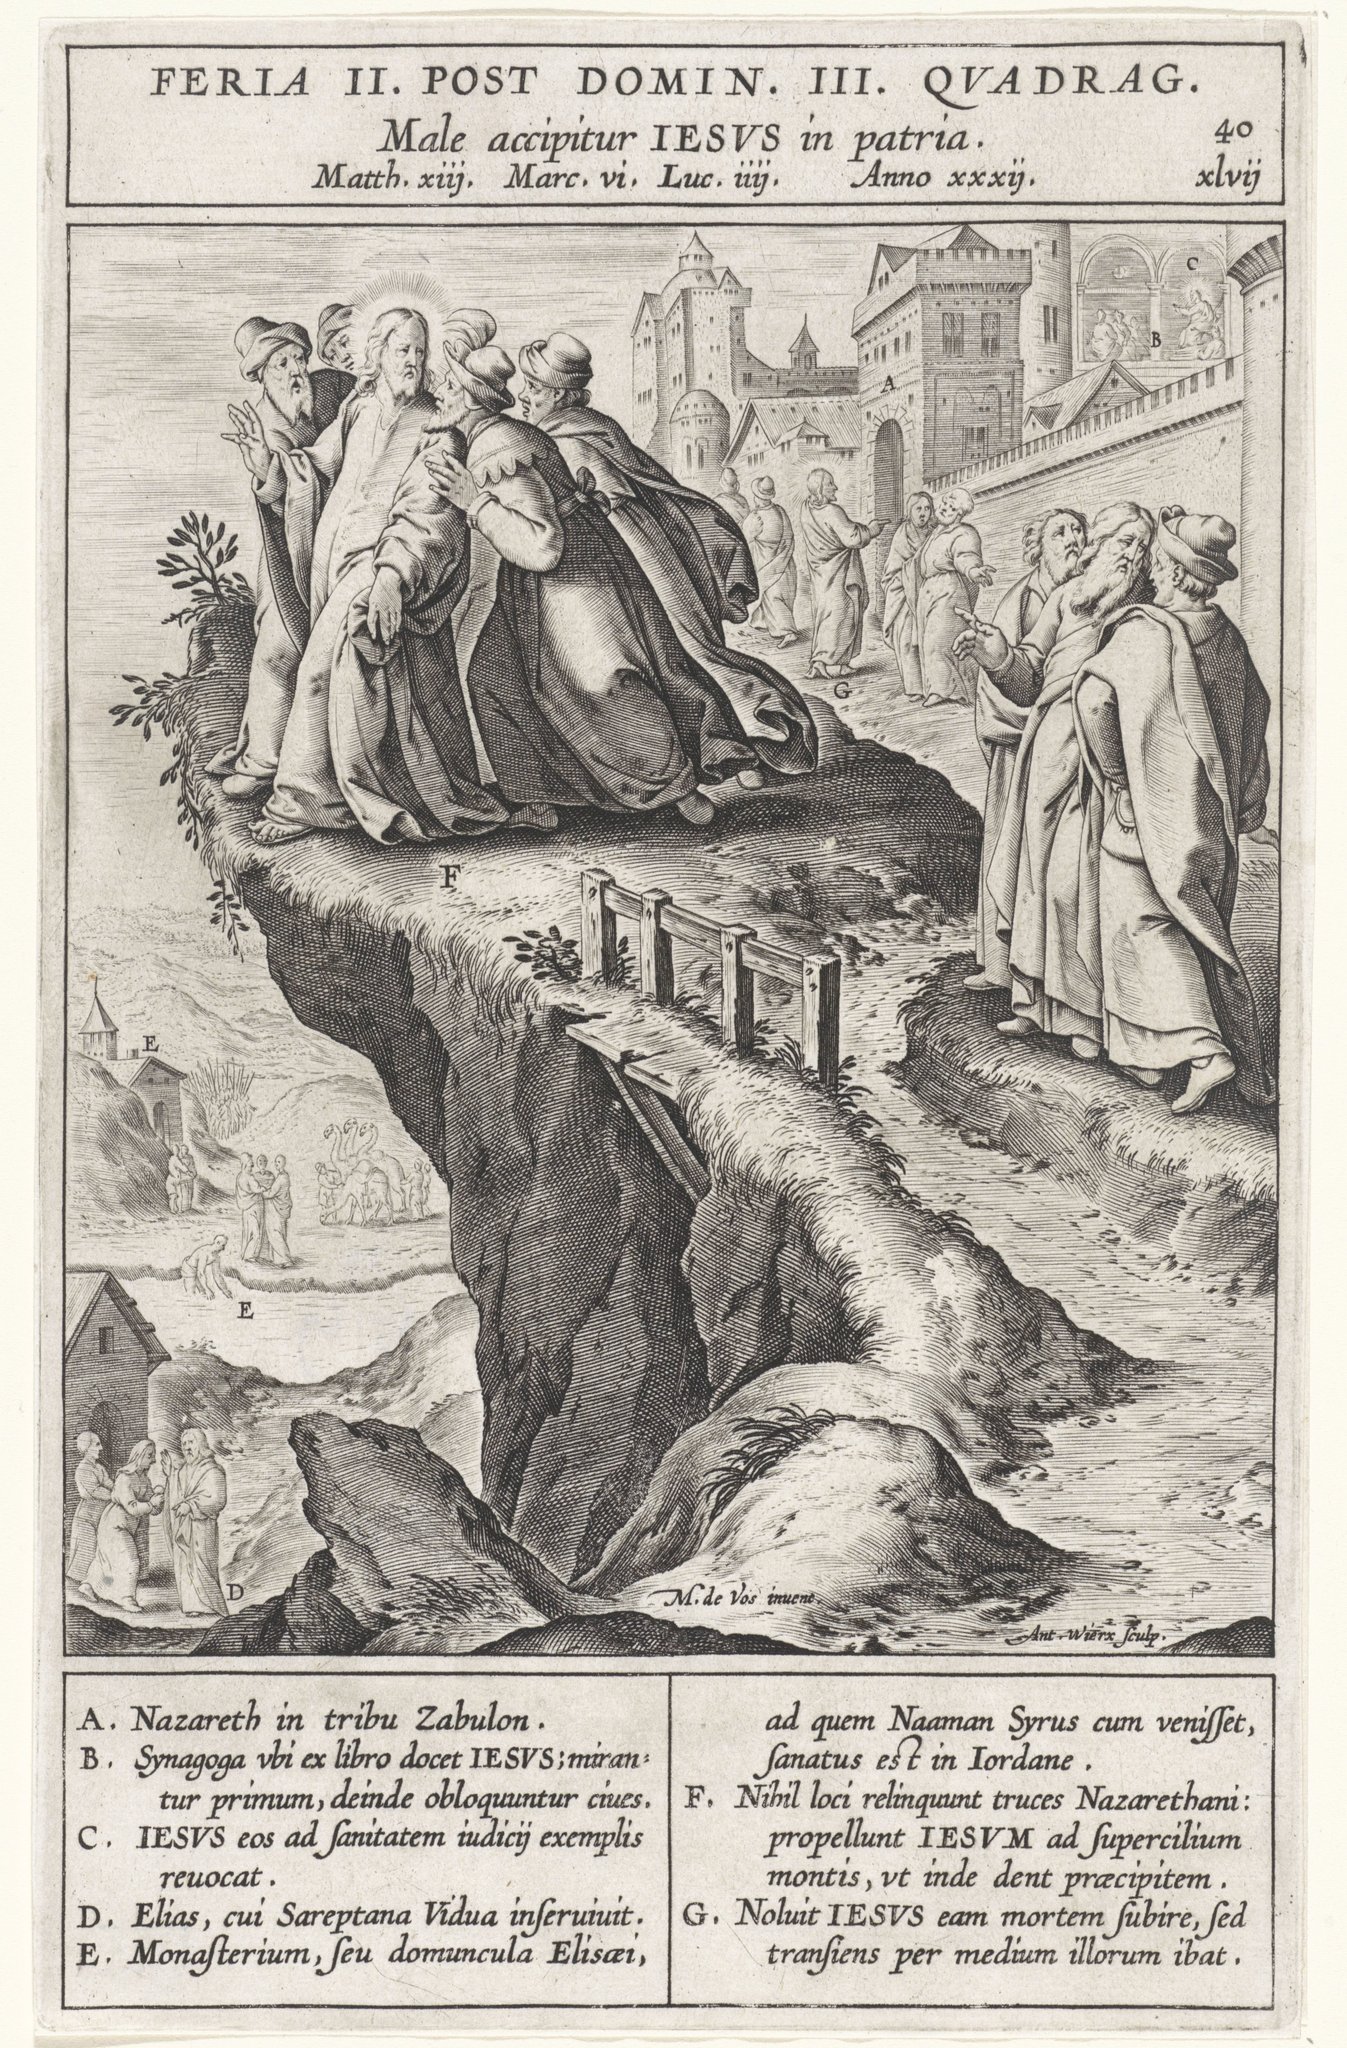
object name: print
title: Inwoners van Nazaret verdrijven Christus uit de stad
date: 1593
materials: paper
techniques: engraving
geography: antwerp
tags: christ, having been chased out of nazareth, passes unharmed through the multitude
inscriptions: collector's mark: Lugt 2165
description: Toen de aanwezigen in de synagoge van Nazaret hoorden dat niemand van hen van huidvraat werd gereinigd, maar wel de Syriër Naäman, ontstaken ze in grote woede. Hierop drijven ze Christus de stad uit, naar de rand van de berg waarop hun stad gebouwd was, om hem in de afgrond te storten. Bij verschillende elementen uit de voorstelling staan letters die corresponderen met de legenda in de marge.